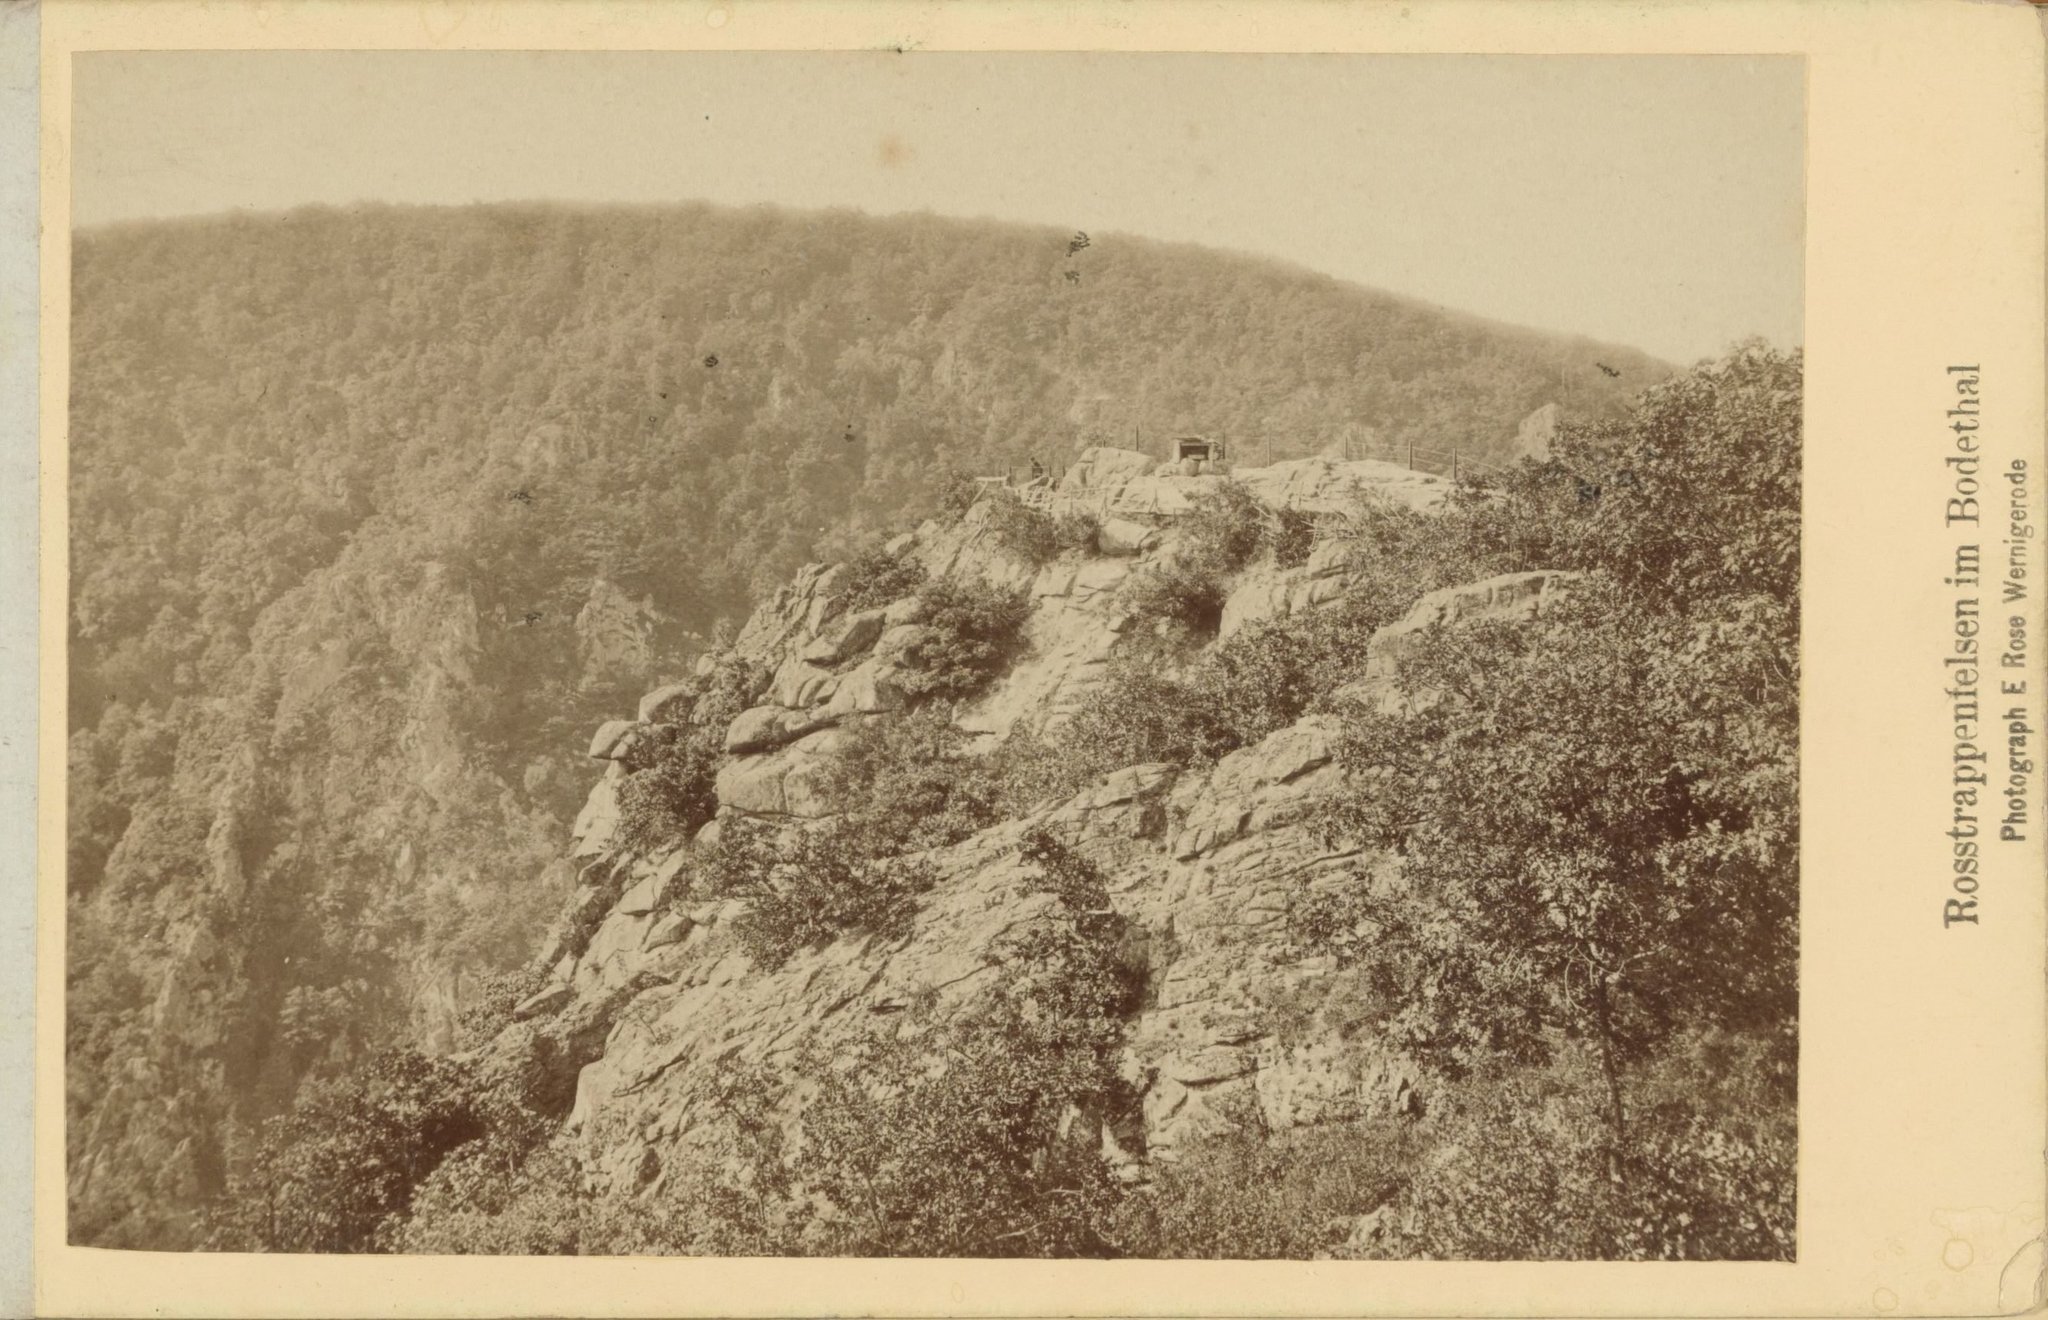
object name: photograph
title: Rosstrappenfelsen im Bodethal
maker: e. rose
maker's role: fotograaf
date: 1870-1890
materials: cardboard, paper, photographic support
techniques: albumen print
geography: harz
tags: travelling; tourism, rock-formations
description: Onderdeel van Album met 38 foto's van een reis door de Harz.